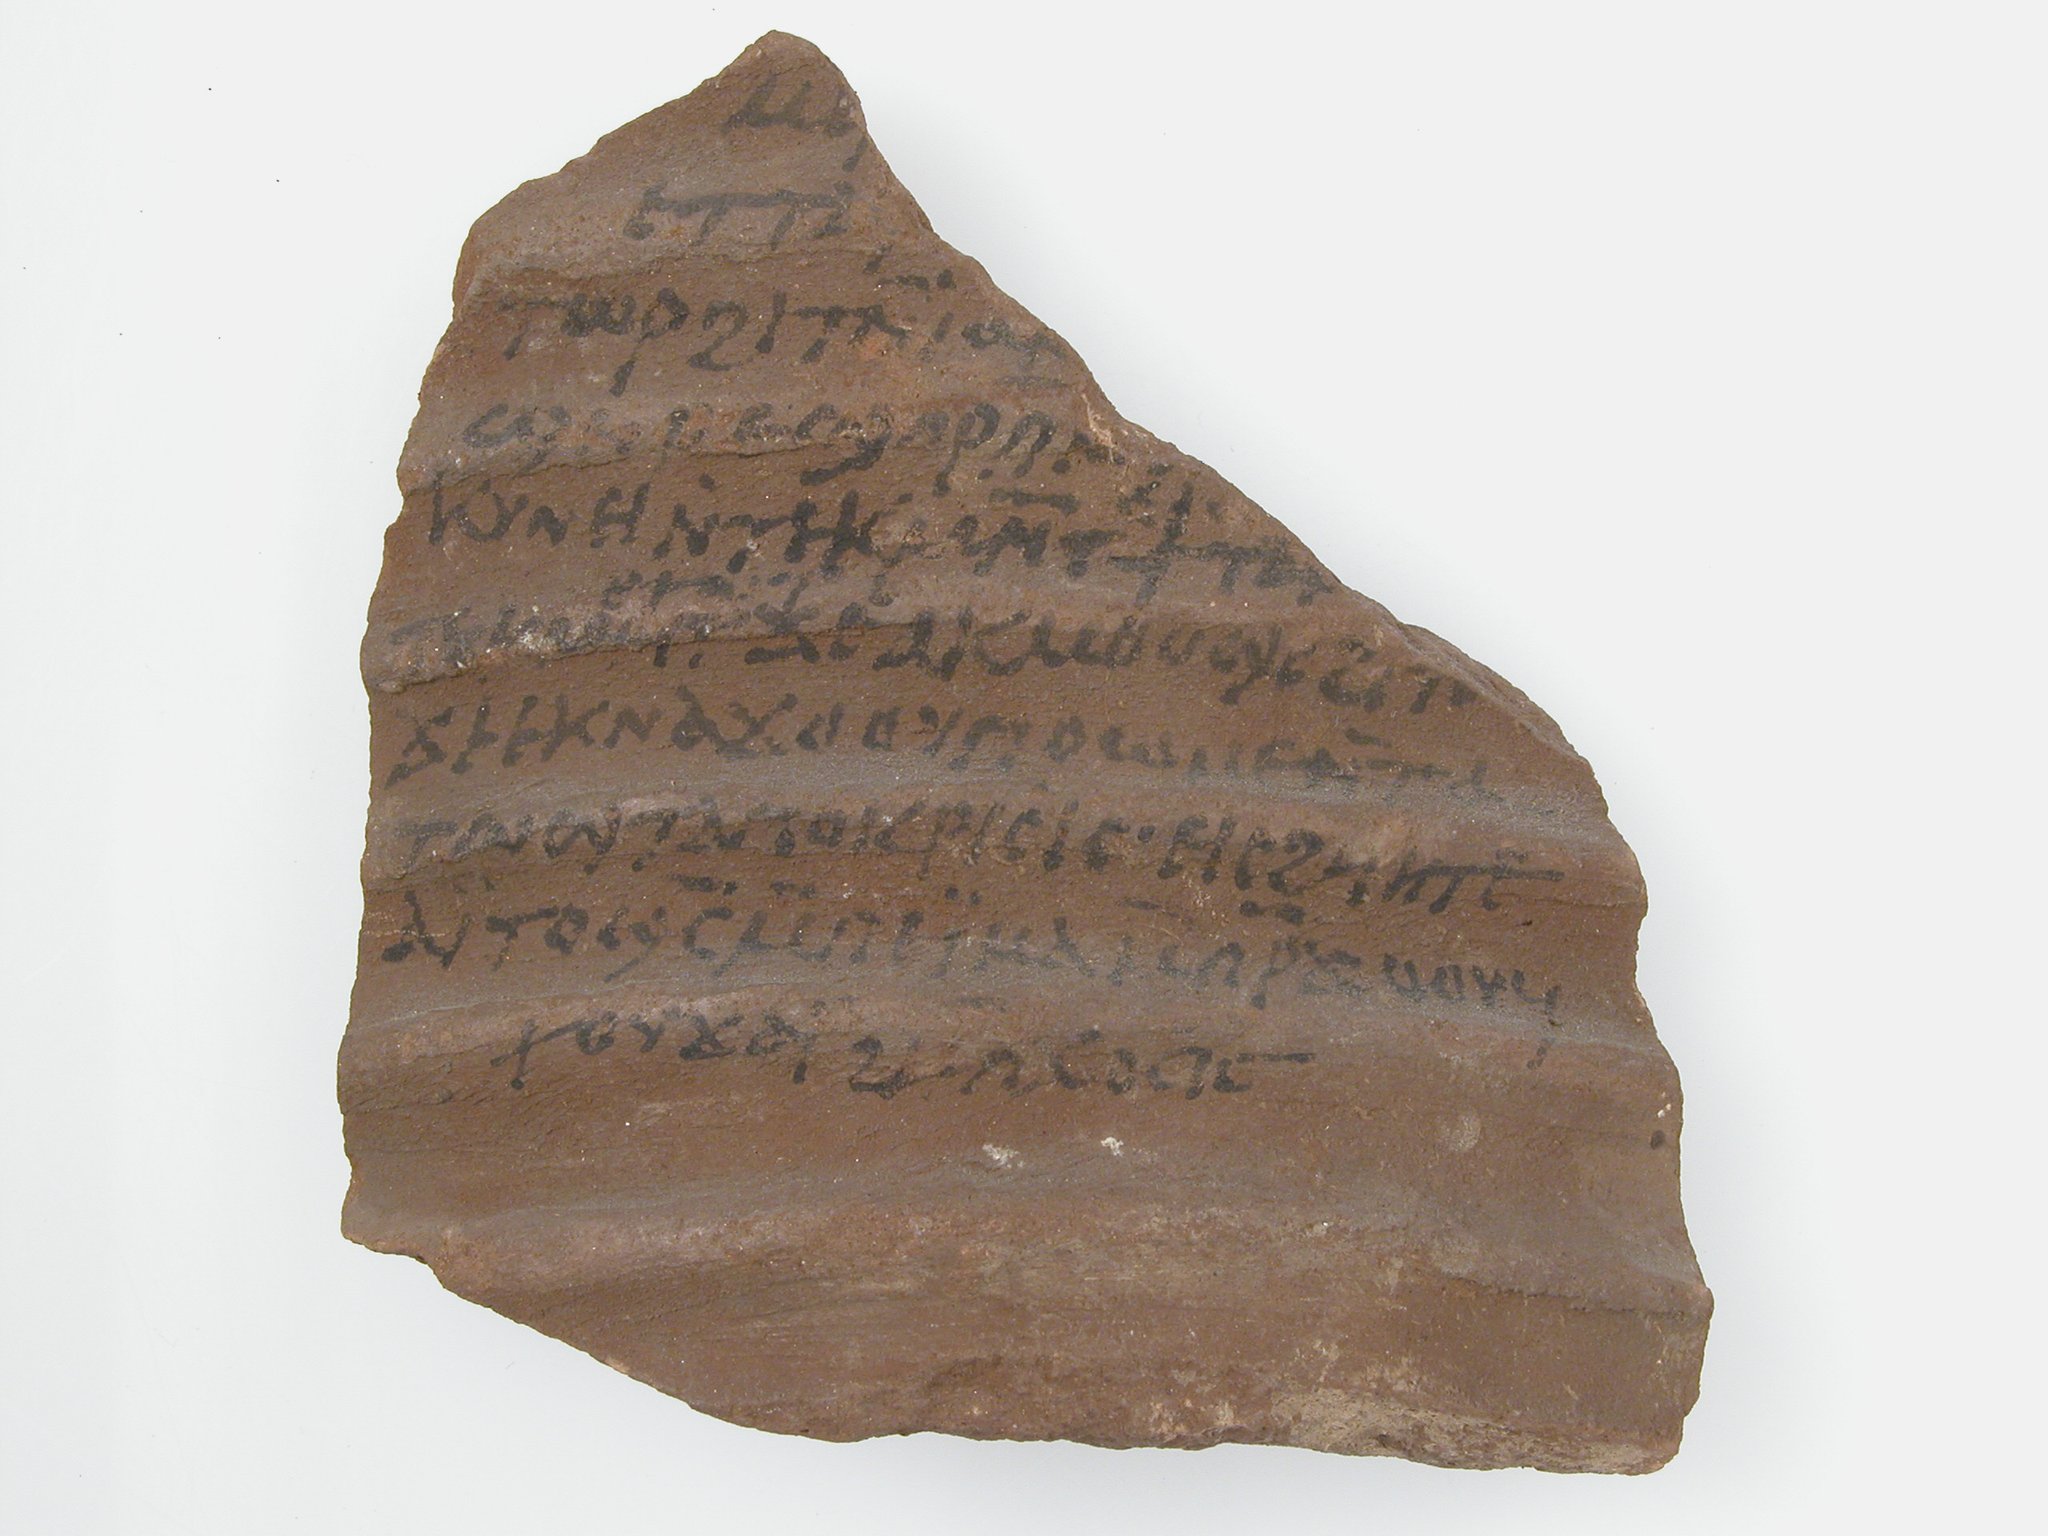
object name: ostrakon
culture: coptic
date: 601-700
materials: ink, pottery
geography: egypt